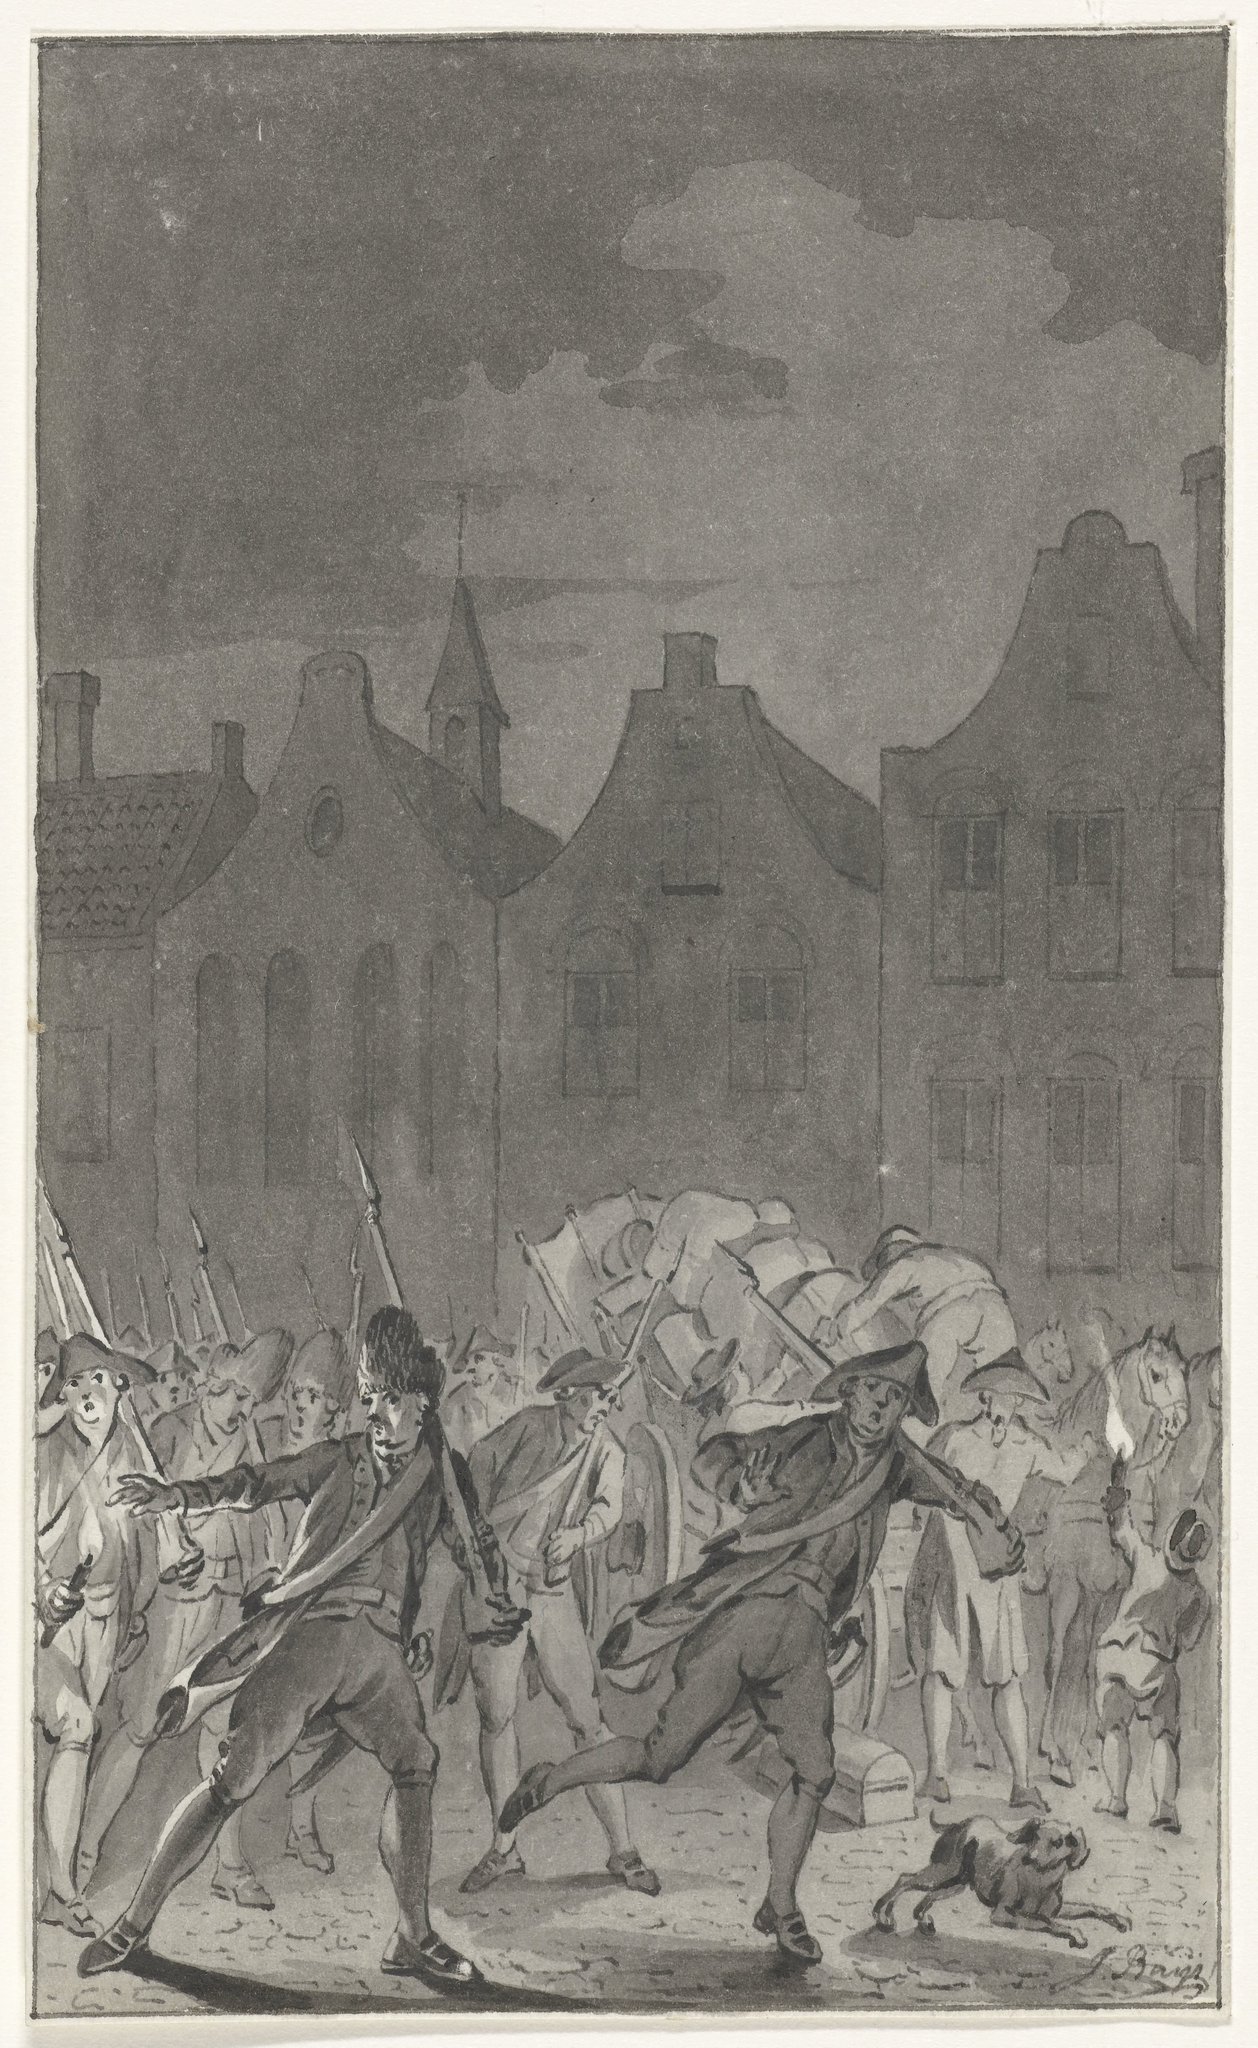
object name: drawing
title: Pruisische troepen op de Neude te Utrecht bij het verlaten van de stad, 16 september 1787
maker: jacobus buys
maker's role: draughtsman, print maker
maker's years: 1724-1801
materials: ink, paper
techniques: brush, pen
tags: nocturnal troop movements, historical events and situations, utrecht